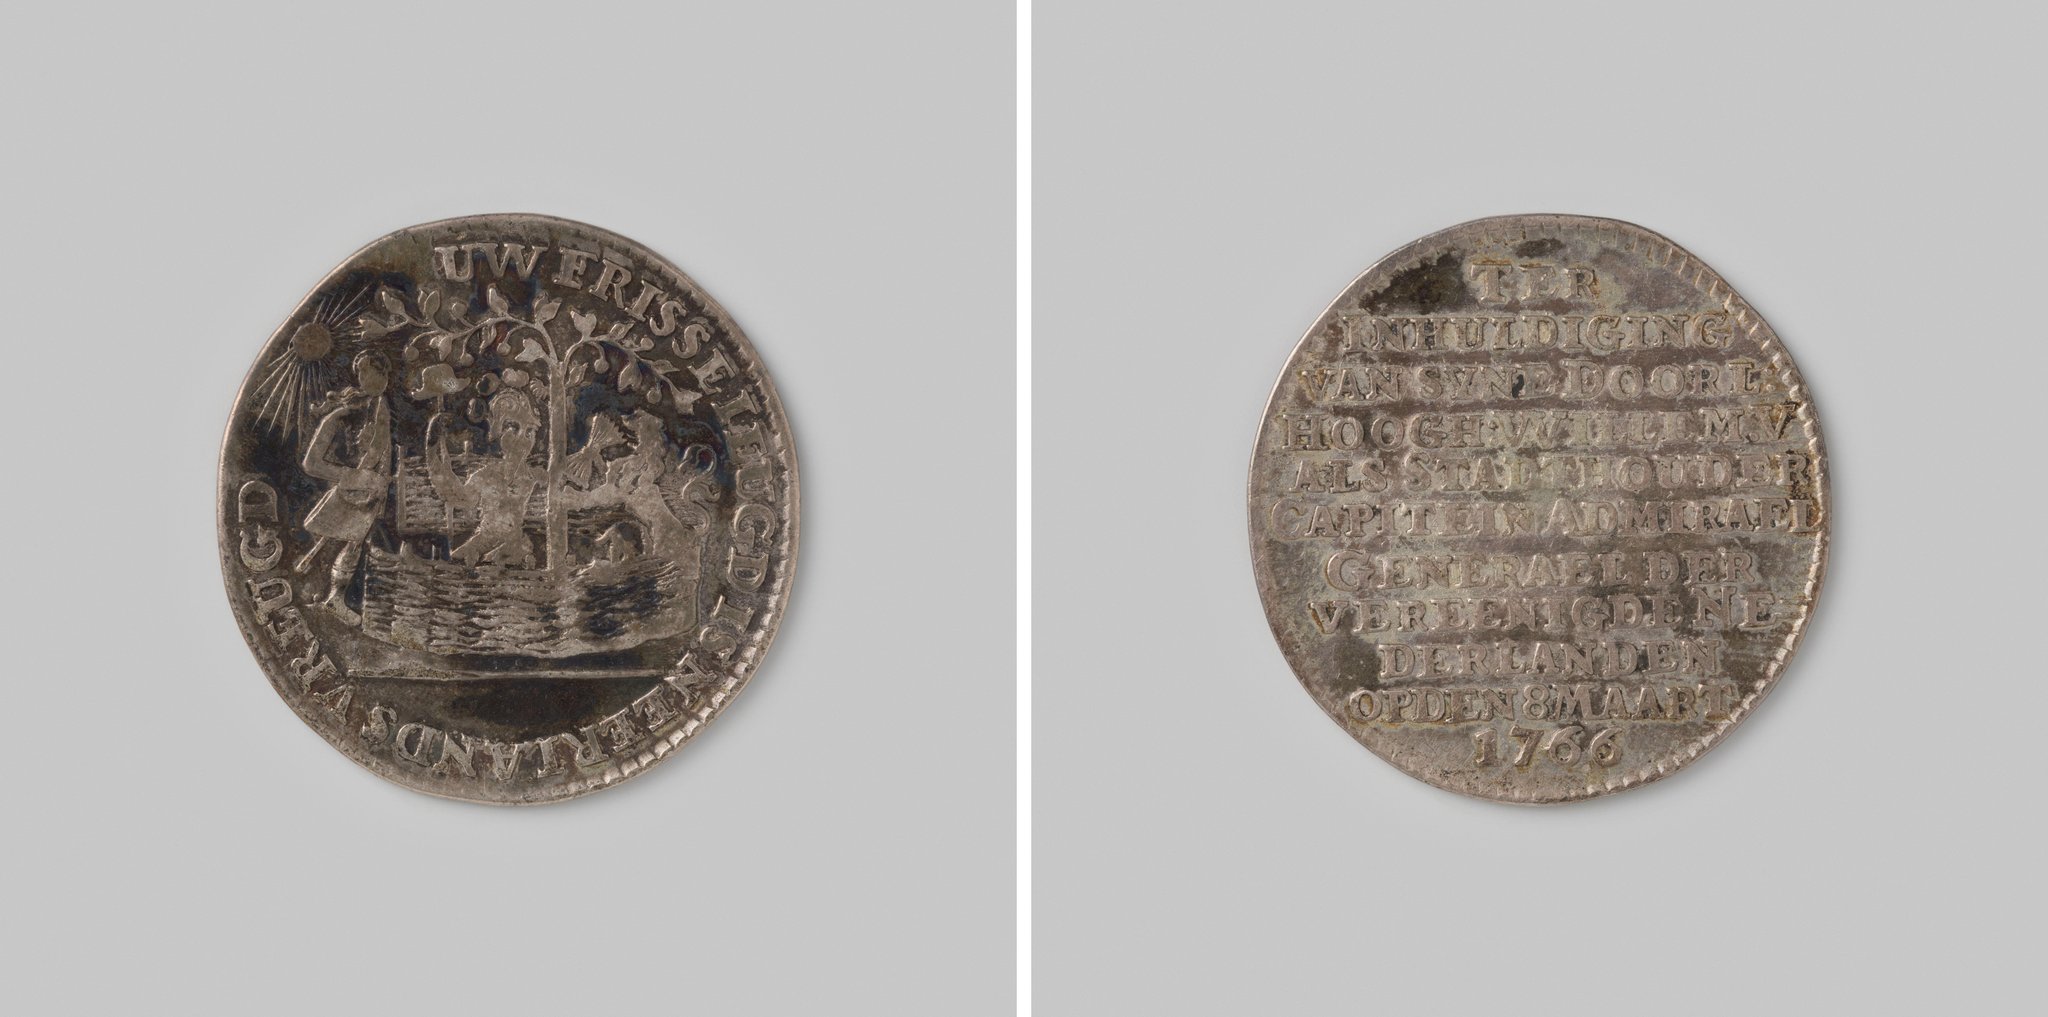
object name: history medal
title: Inhuldiging van stadhouder prins Willem V 1766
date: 1766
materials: silver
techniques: striking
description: Zilveren penning, op de voorzijde een Hollandse tuin waarin Nederlandse Maagd, Nederlandse leeuw en oranjeboom waarin links Willem V, met degen, binnentreedt, met omschrift, op de keerzijde elf regels tekst.